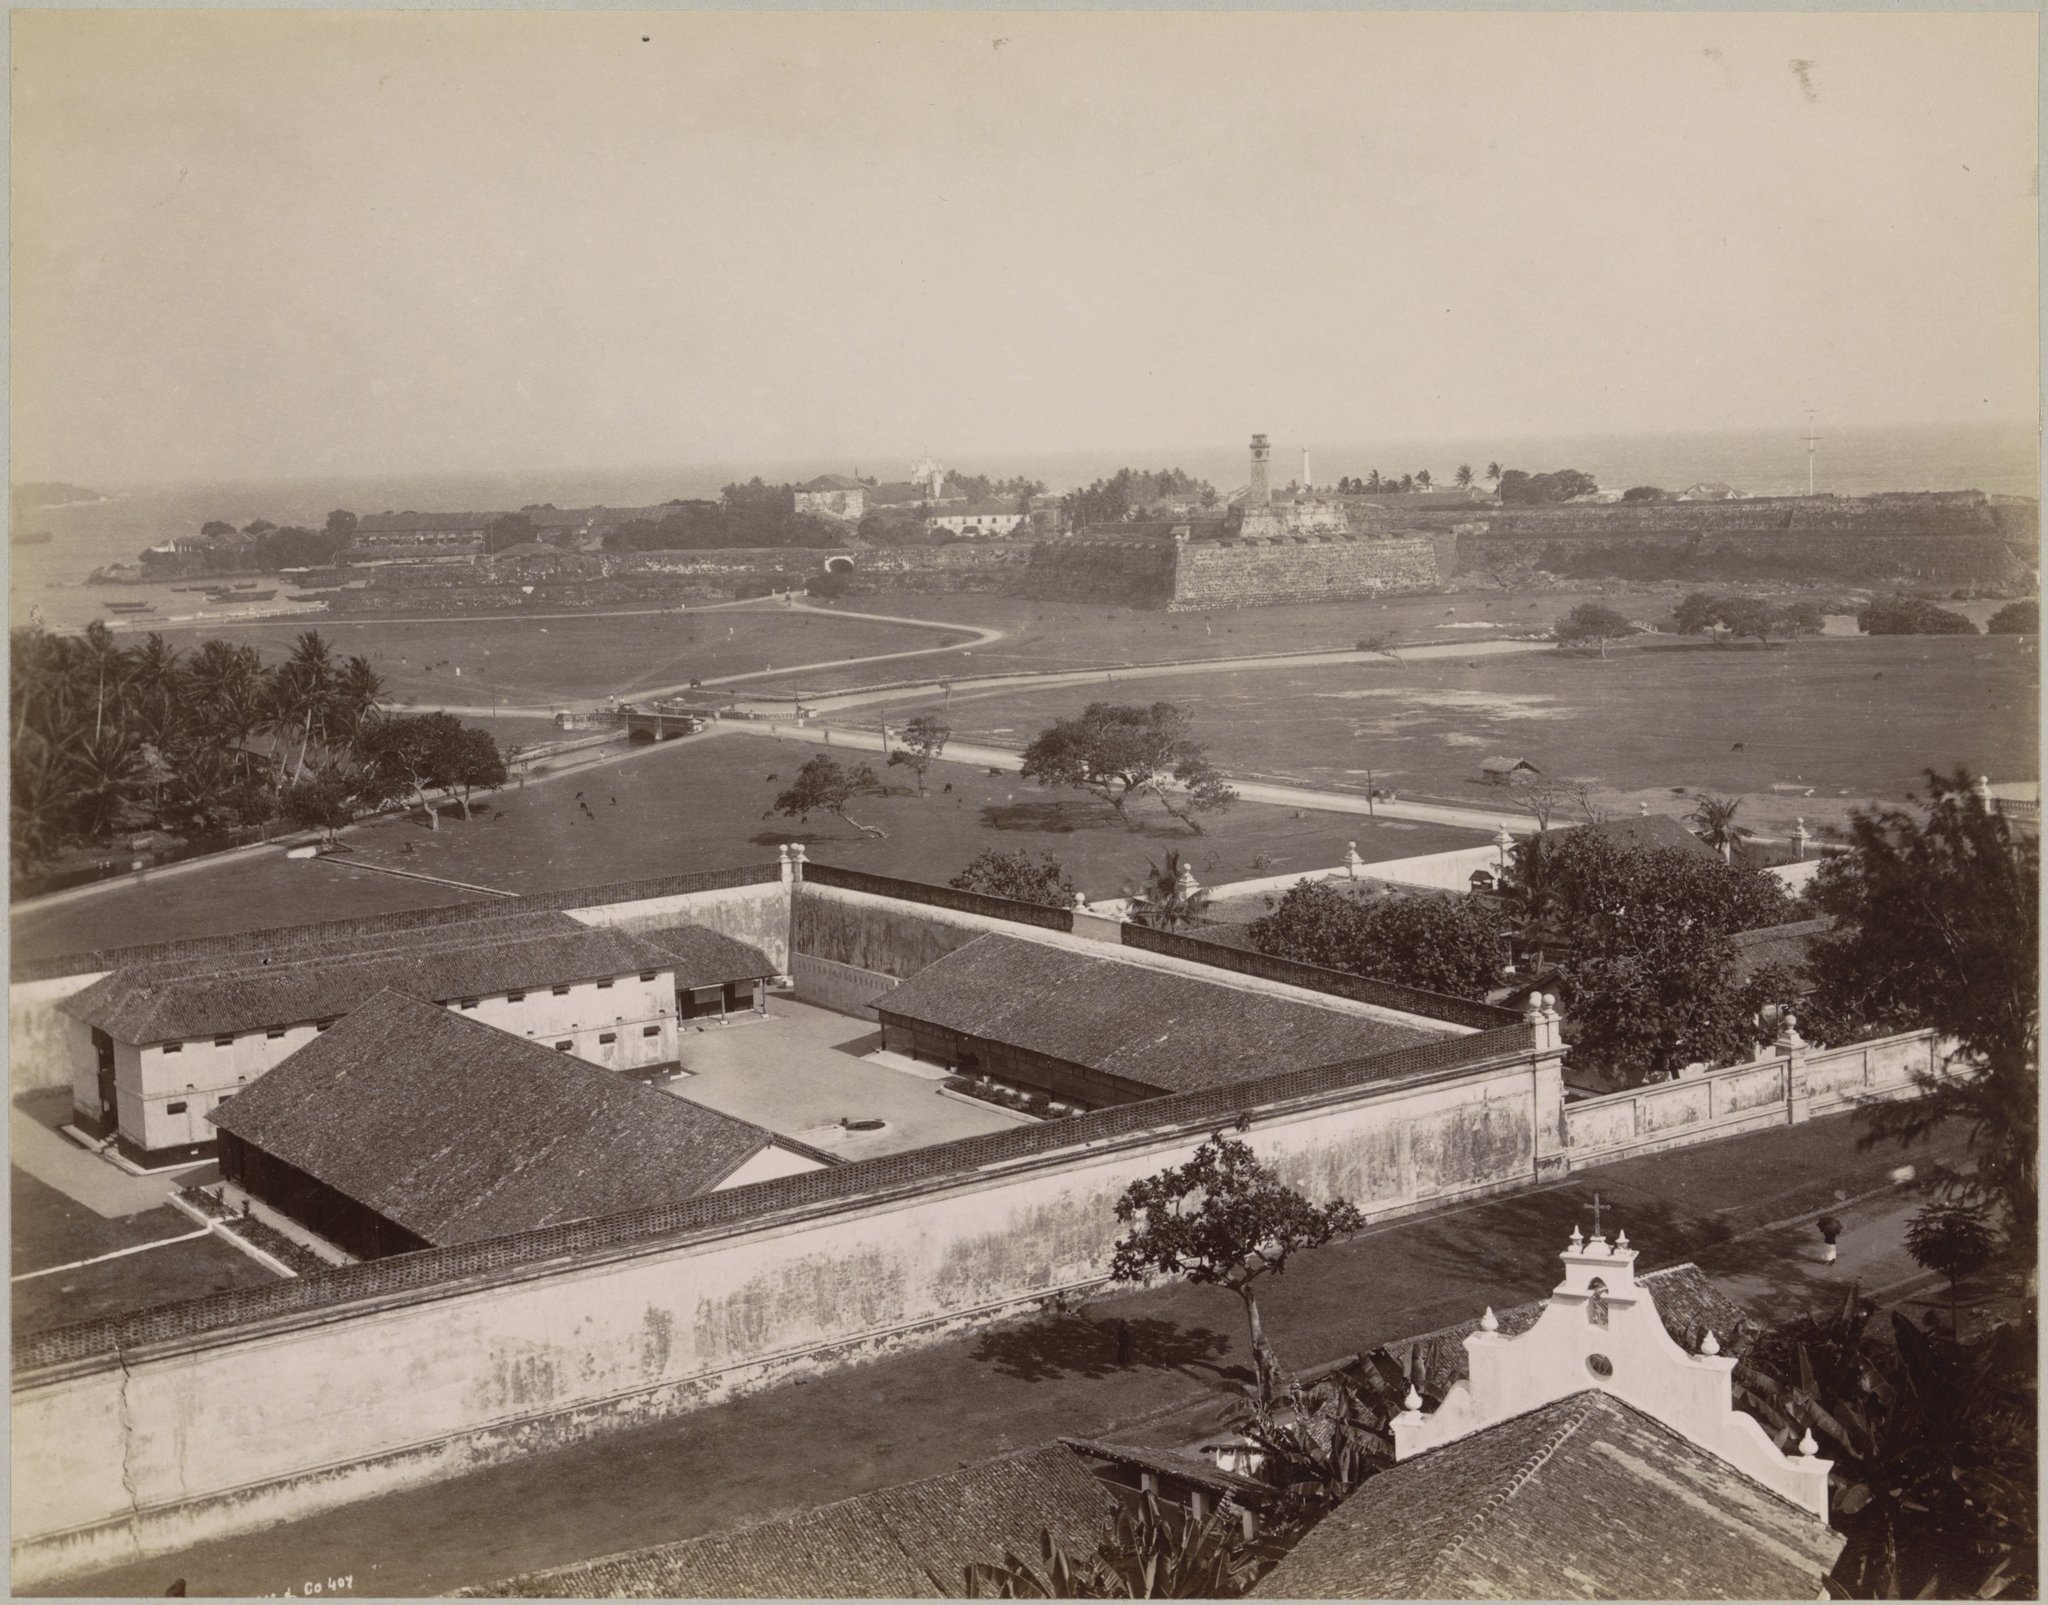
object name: photograph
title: View of Galle, Sri Lanka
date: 1895-1915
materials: cardboard, paper, photographic support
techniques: albumen print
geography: galle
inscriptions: inscription: ‘13. Galle.’, inscription: ‘[?] & Co. 407’